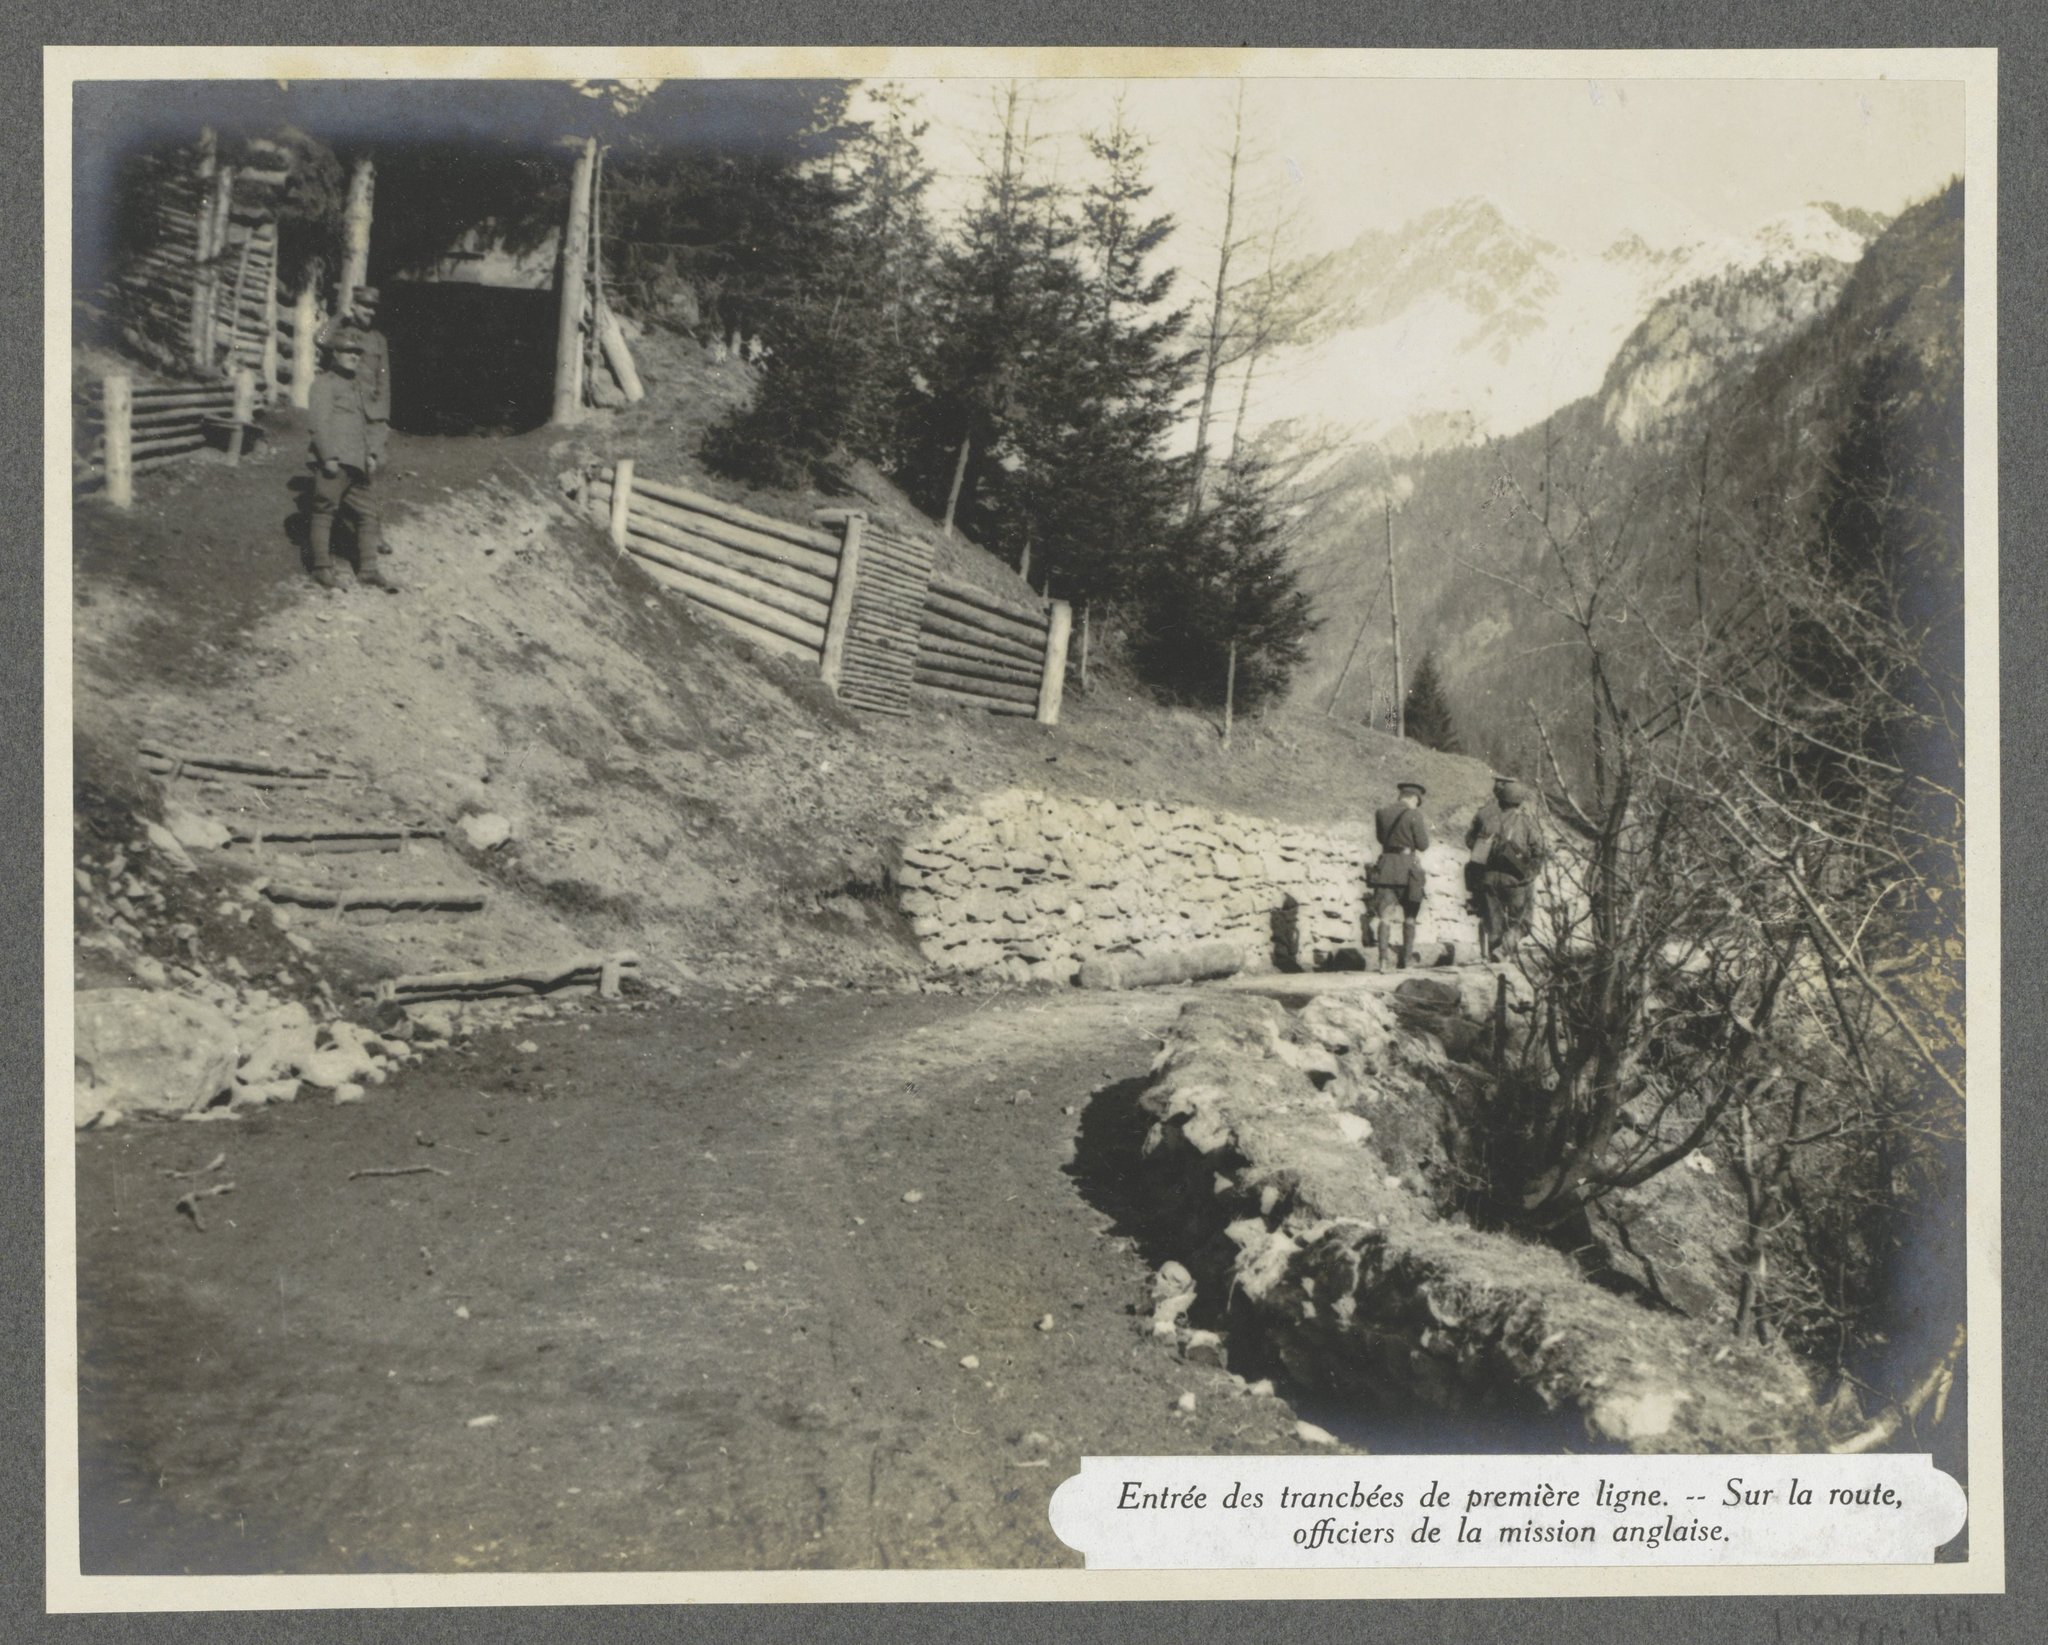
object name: photograph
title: Entrée des tranchées de première ligne. -- Sur la route, officiers de la mission anglaise.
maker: henri de rothschild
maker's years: 1872-1947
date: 1916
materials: photographic support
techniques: gelatin silver print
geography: dolomites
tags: war (+ land forces), trenches (+ land forces), road, path, mountain-range, snow peaks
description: Links staan militairen, vermoedelijk Italianen, bovenaan een trap die leidt naar de ingang van loopgraven in een versterkte berghelling. Rechts lopen leden van een Engelse missie over een pad. Onderdeel van Fotoalbum Medische missie H. de Rothschild naar het Italiaanse front 1916.